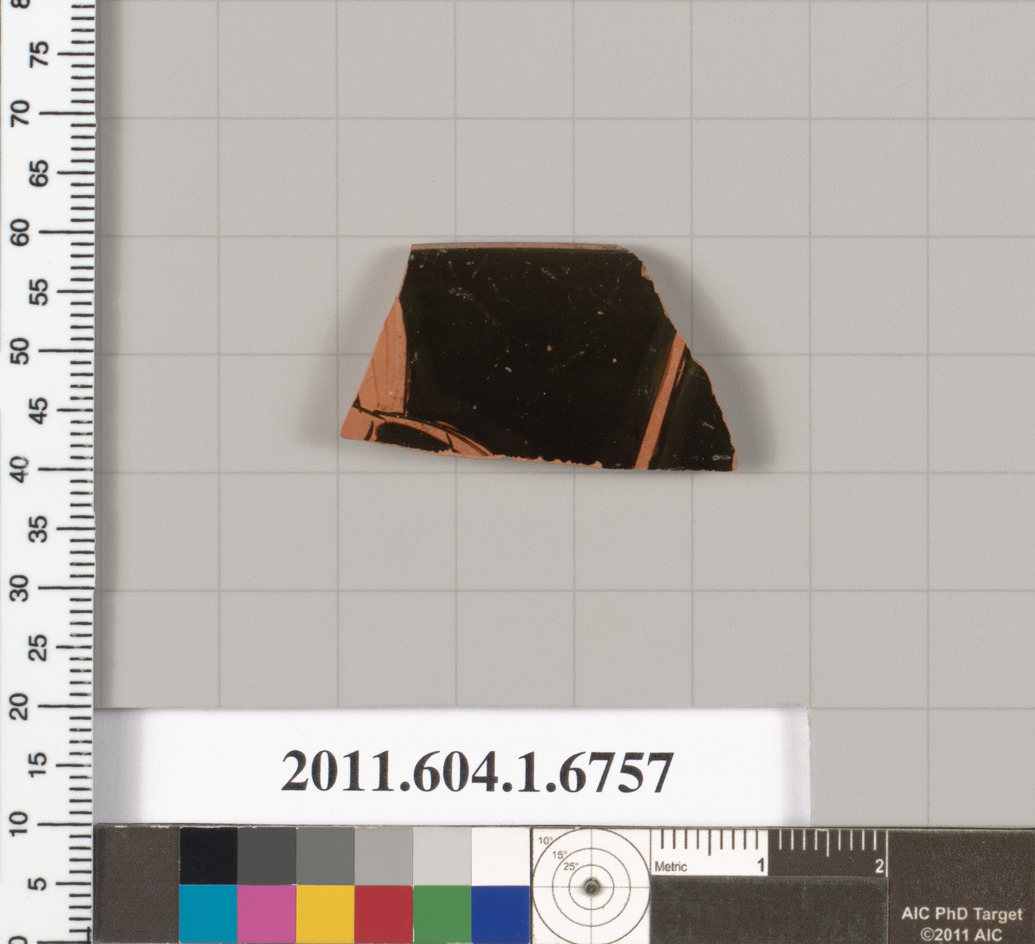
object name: kylix fragment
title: Terracotta rim fragment of a kylix (drinking cup)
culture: greek, attic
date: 490-470 BCE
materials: terracotta